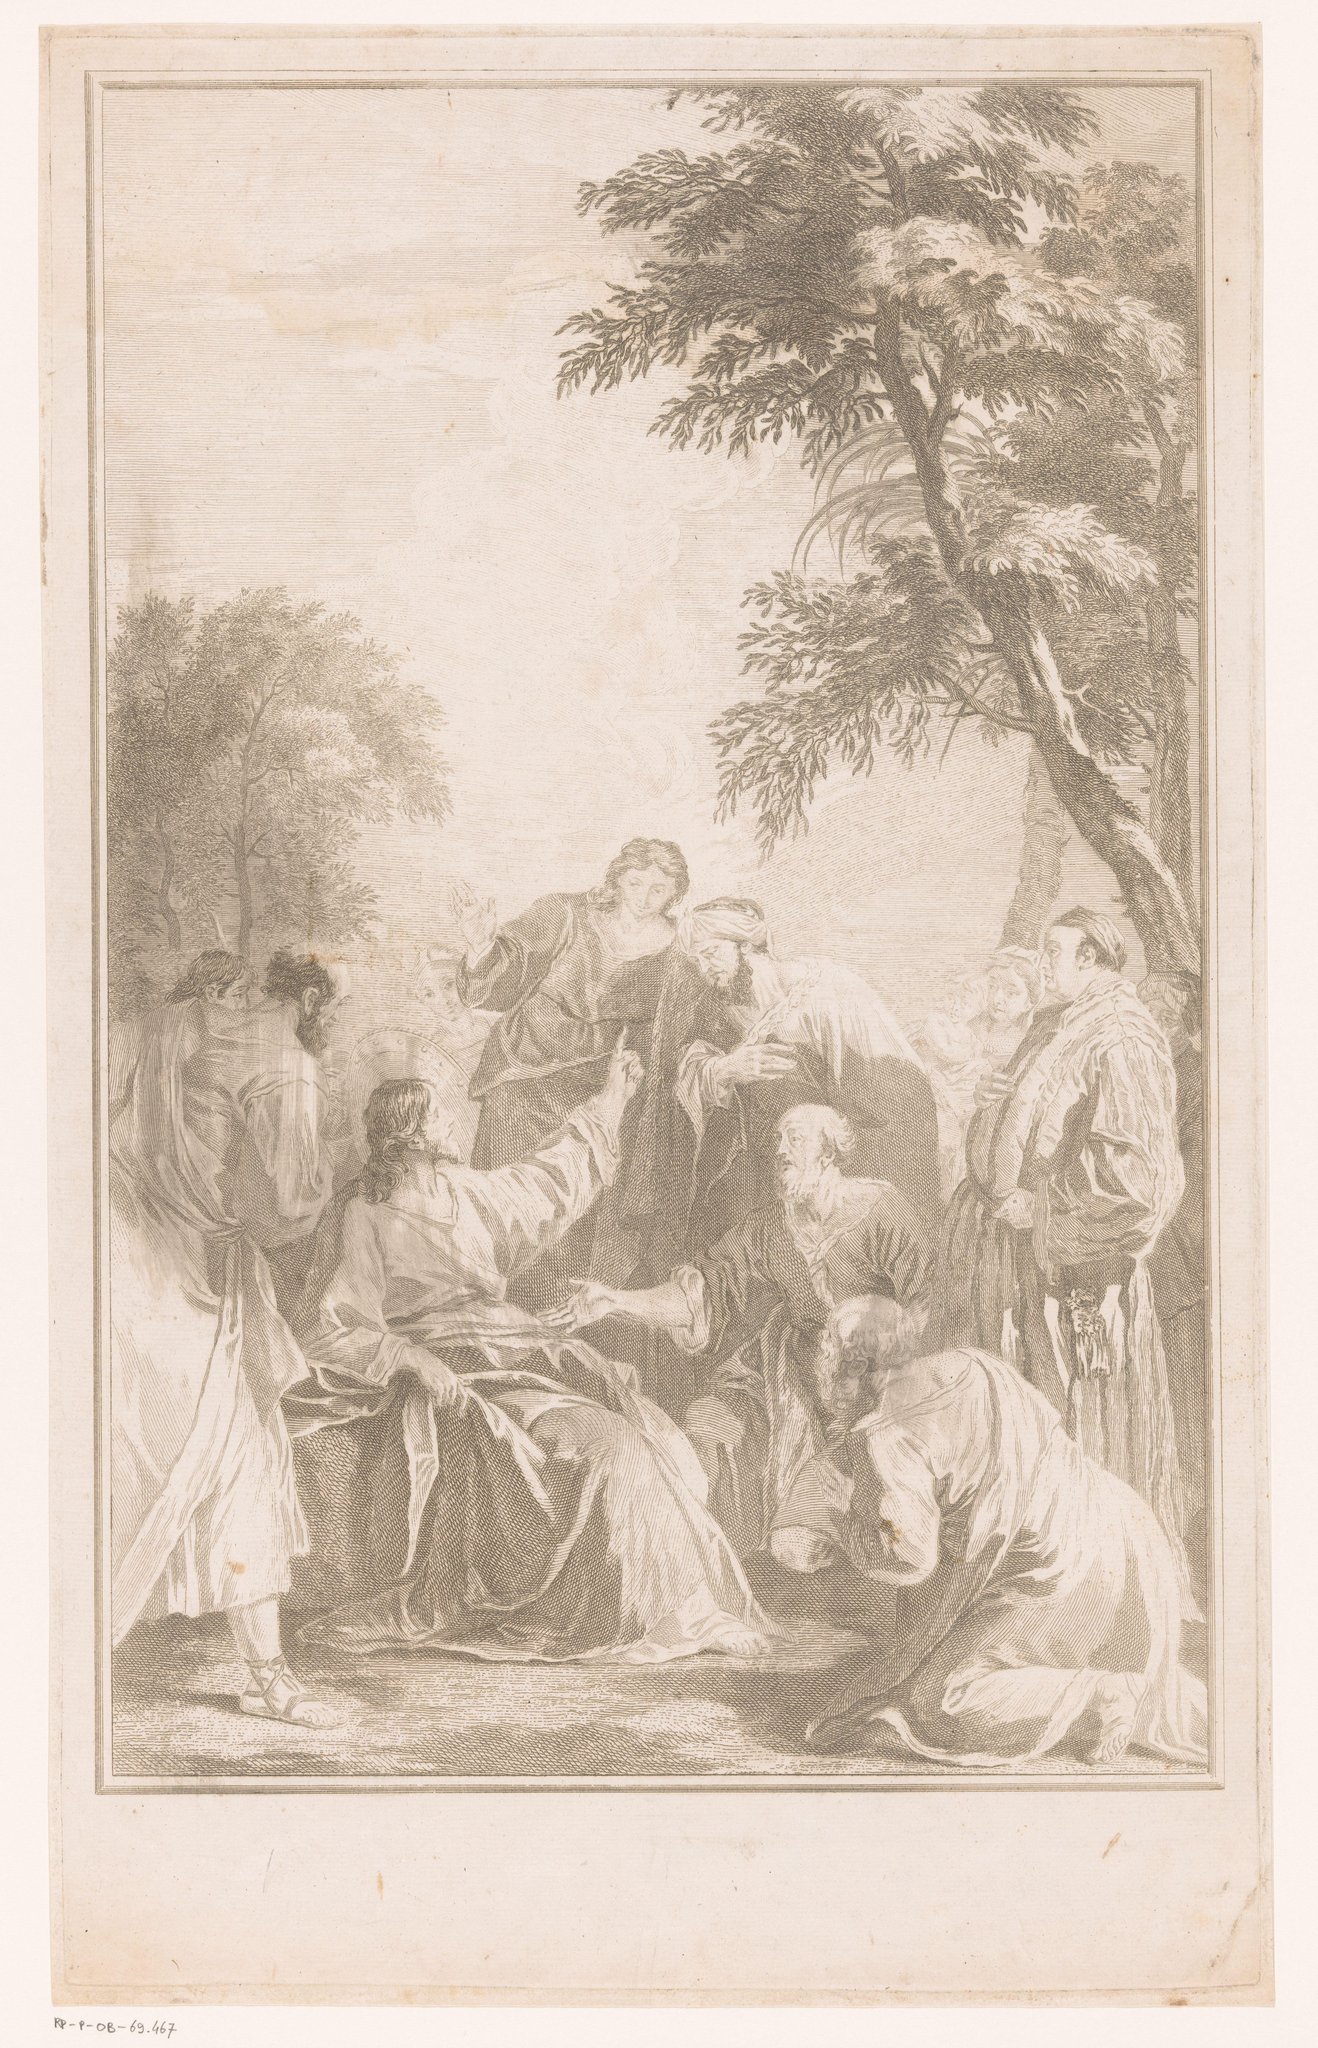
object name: print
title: Bergrede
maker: jean michel liotard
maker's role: print maker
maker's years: 1702-1796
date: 1712-1796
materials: paper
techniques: etching, intaglio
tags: christ's sermon on the mount (matthew 5-7)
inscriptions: collector's mark: Lugt 2228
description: Maakt deel uit van een serie met prenten naar Sebastiano Ricci in de collectie van Joseph Smith (British Museum, inv.nr. 1871,0429.261).